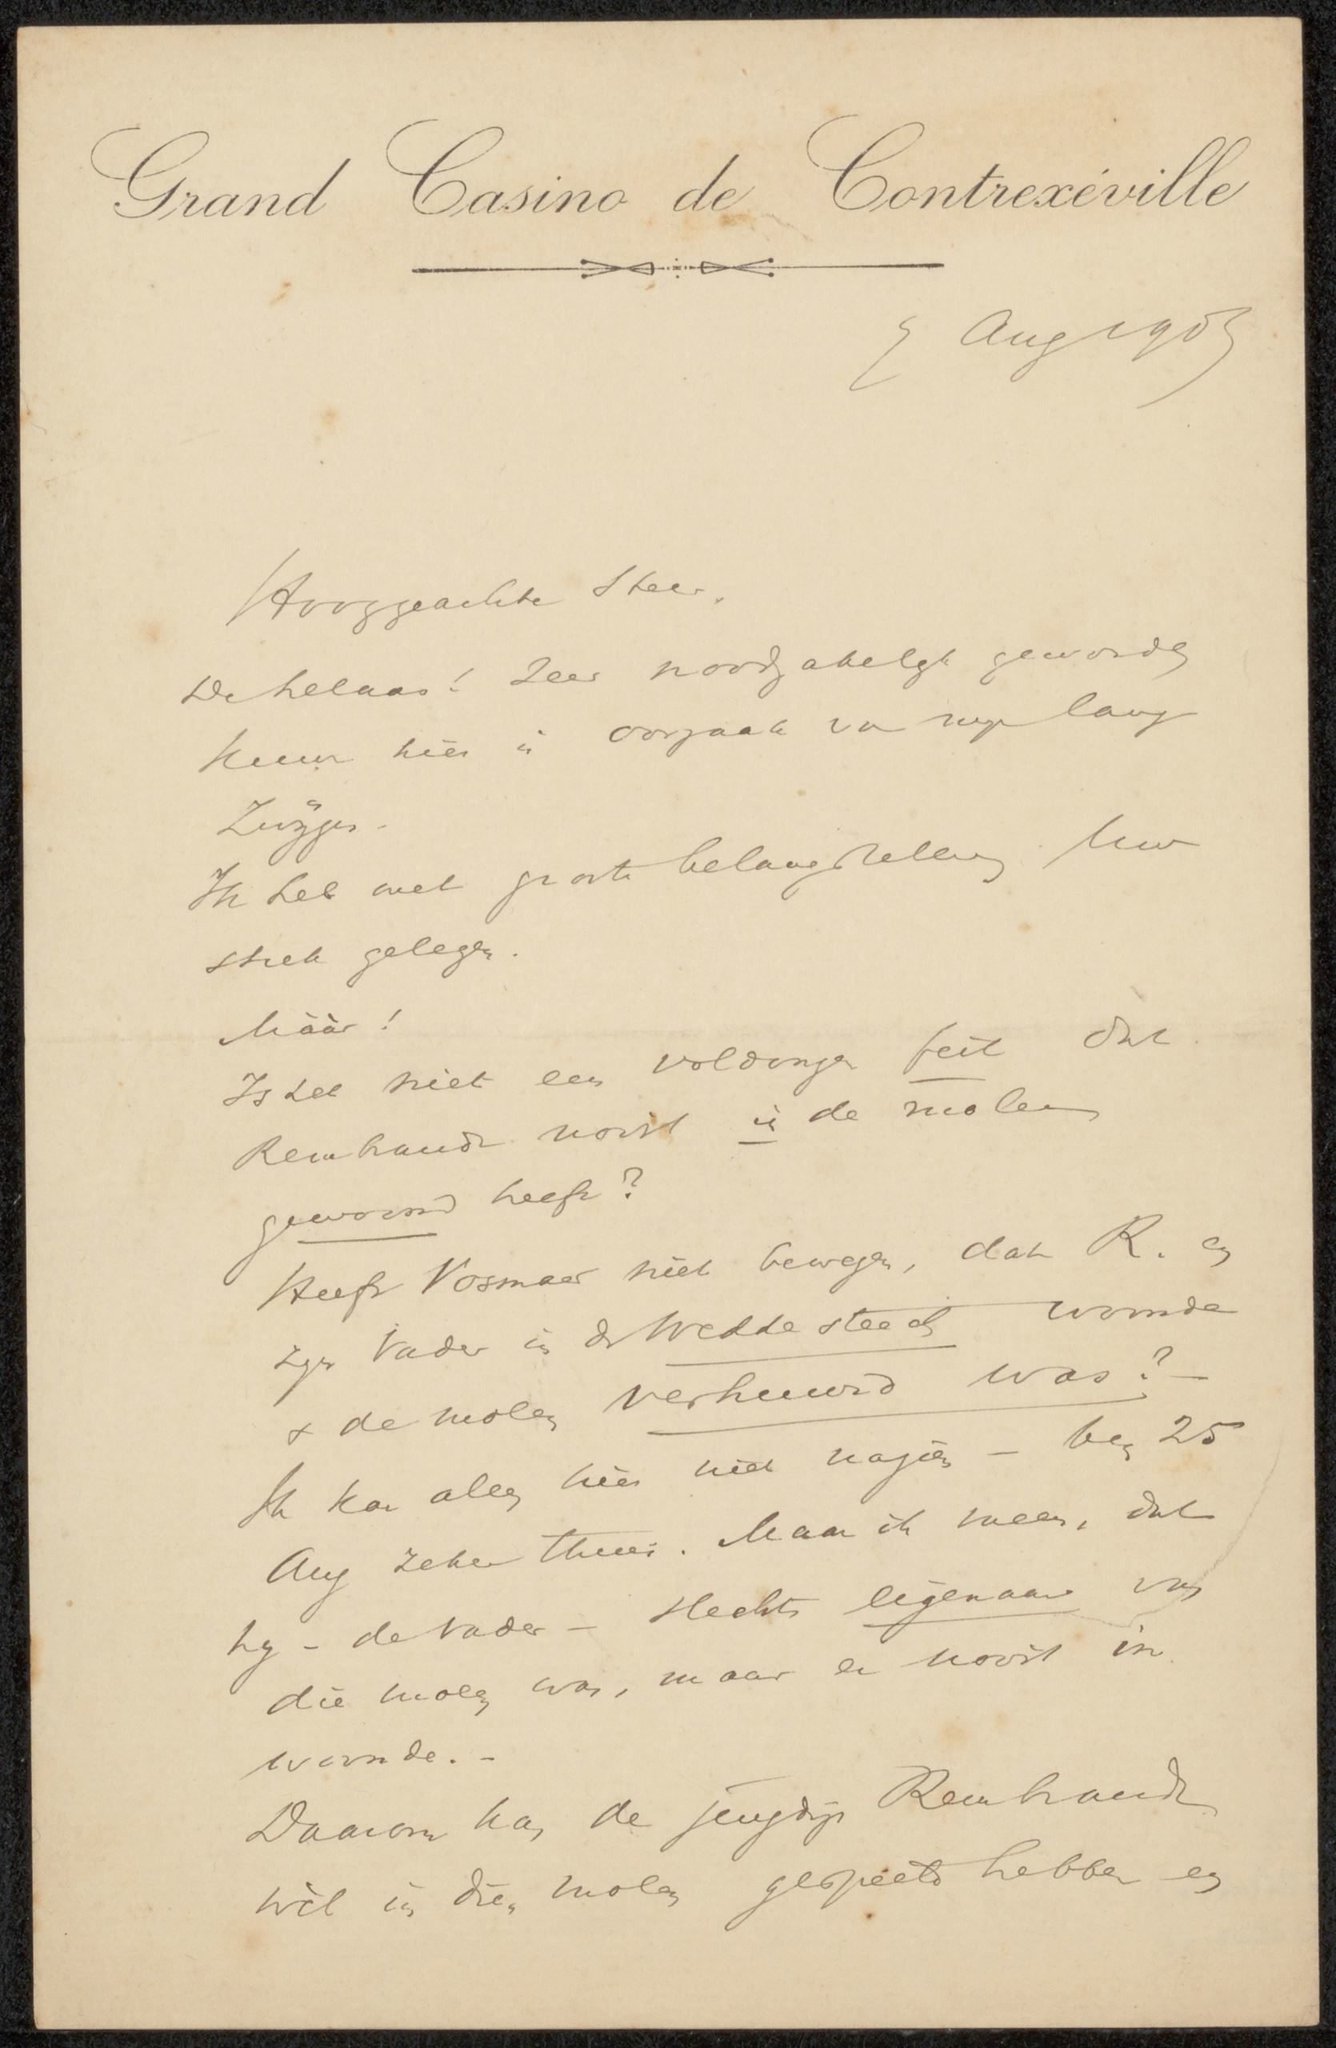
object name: letter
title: Brief aan Philip Zilcken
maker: abraham bredius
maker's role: kunsthistoricus, museumdirecteur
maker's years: 1855-1946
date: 1903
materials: ink, paper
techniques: pen, printing, writing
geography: contrexéville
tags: painter, print maker, draughtsman, vincent van gogh, carel vosmaer, leiden, rembrandt van rijn, philip zilcken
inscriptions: collector's mark: ‘RPK’